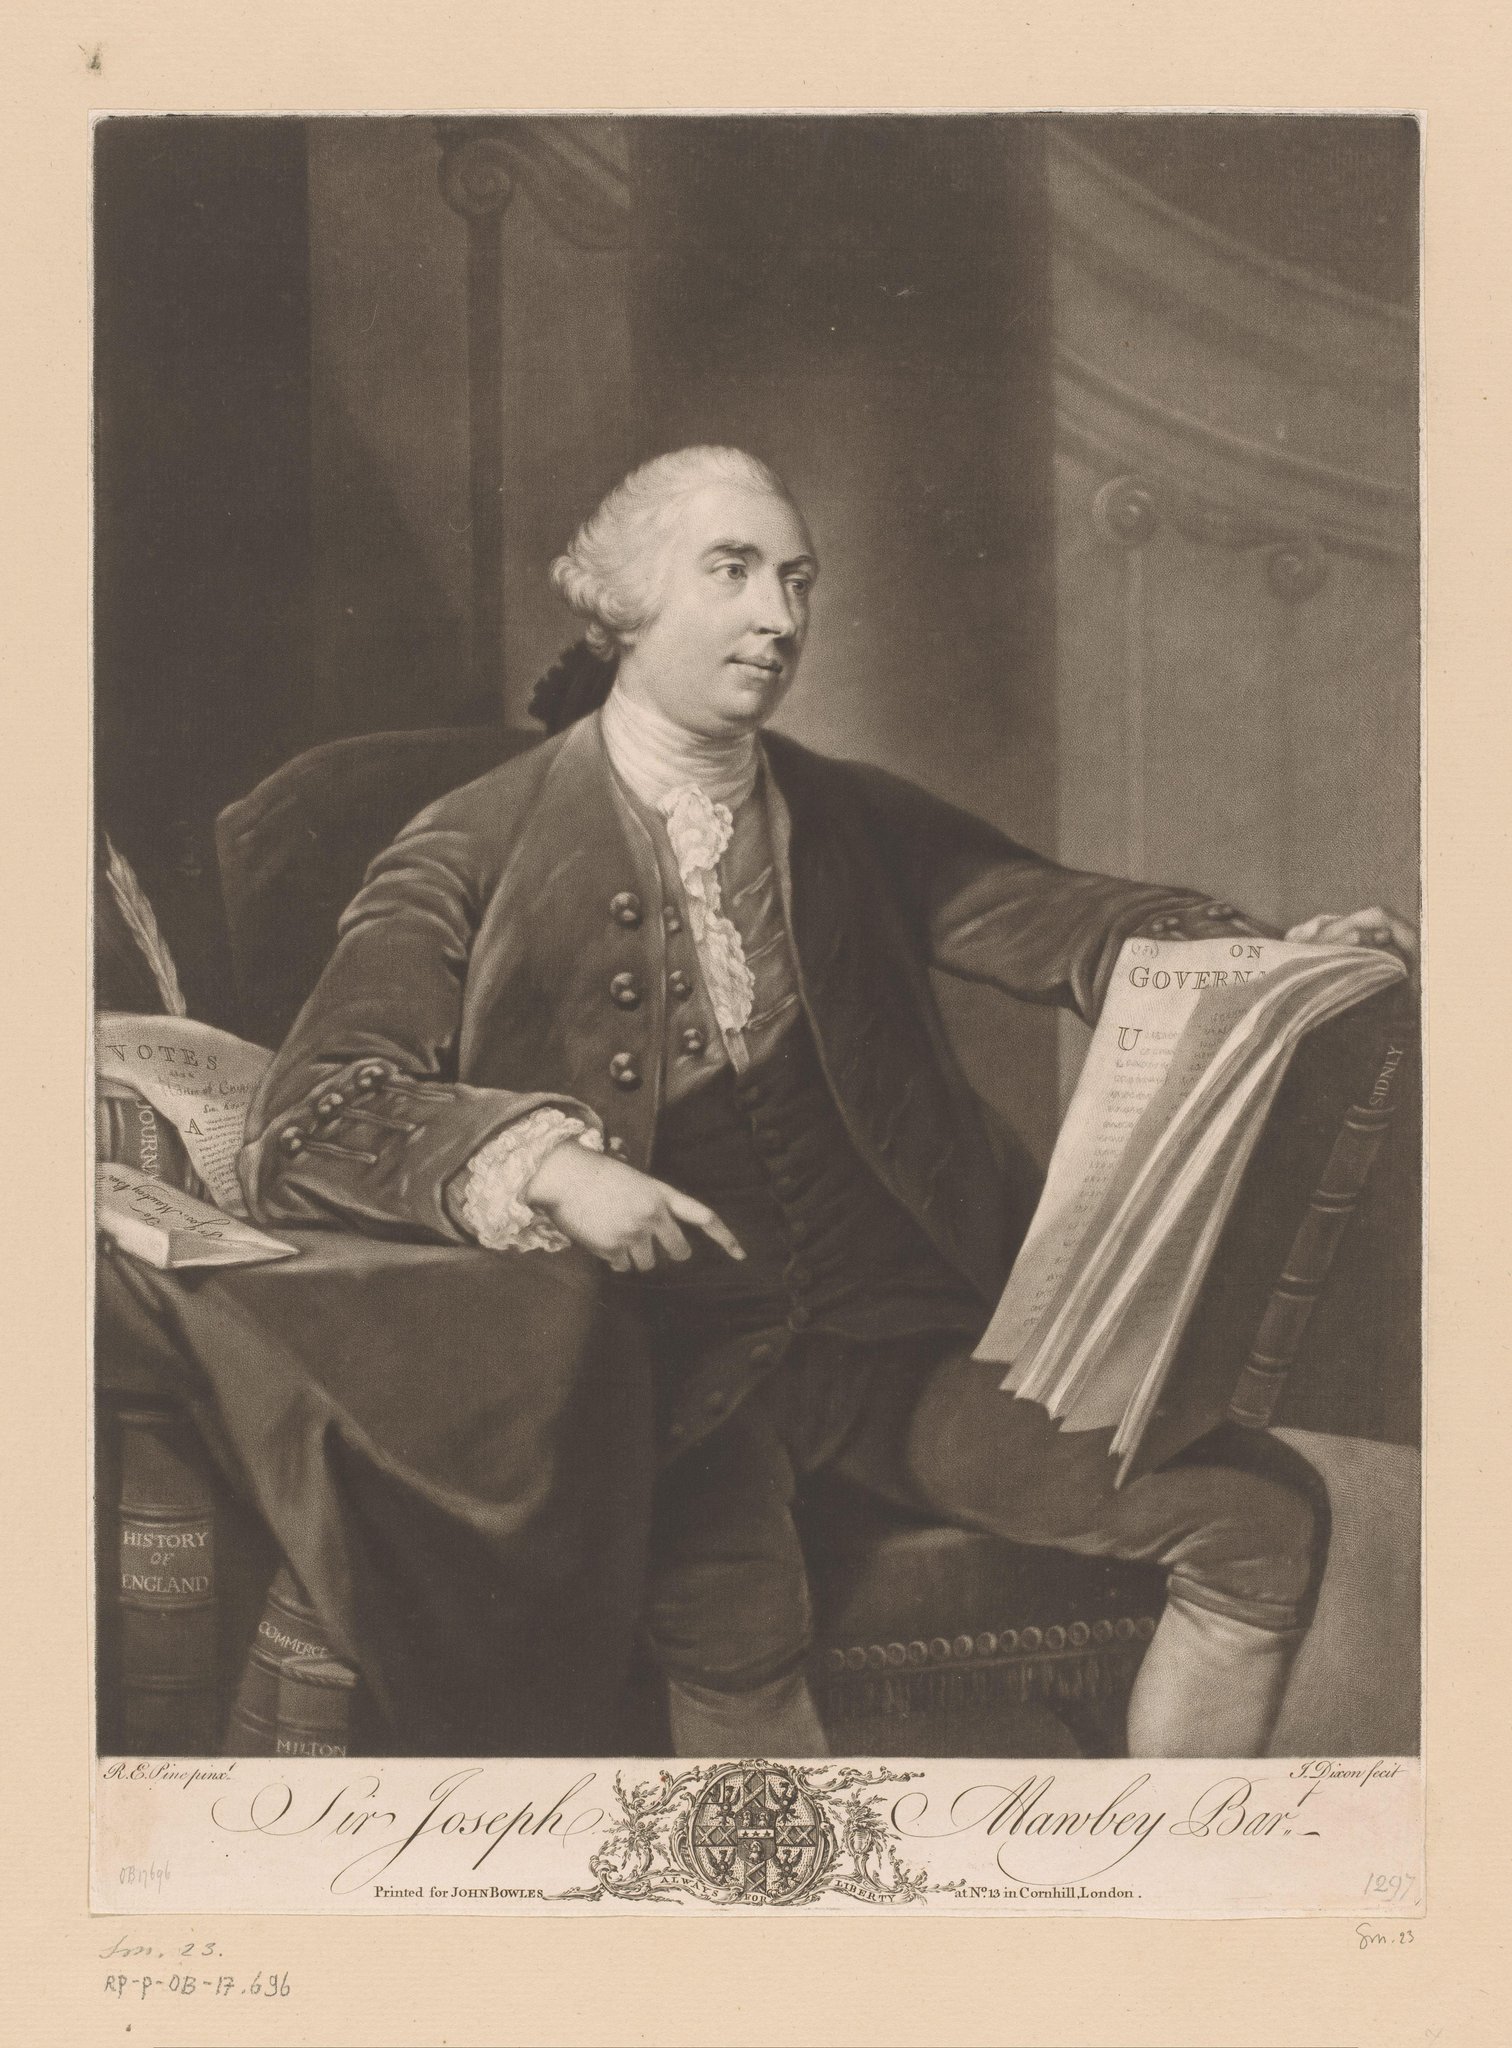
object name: print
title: Portret van Joseph Mawbey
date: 1765-1779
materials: paper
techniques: etching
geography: london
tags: politician, historical persons, politician, e.g. party leader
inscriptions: collector's mark: Lugt 240